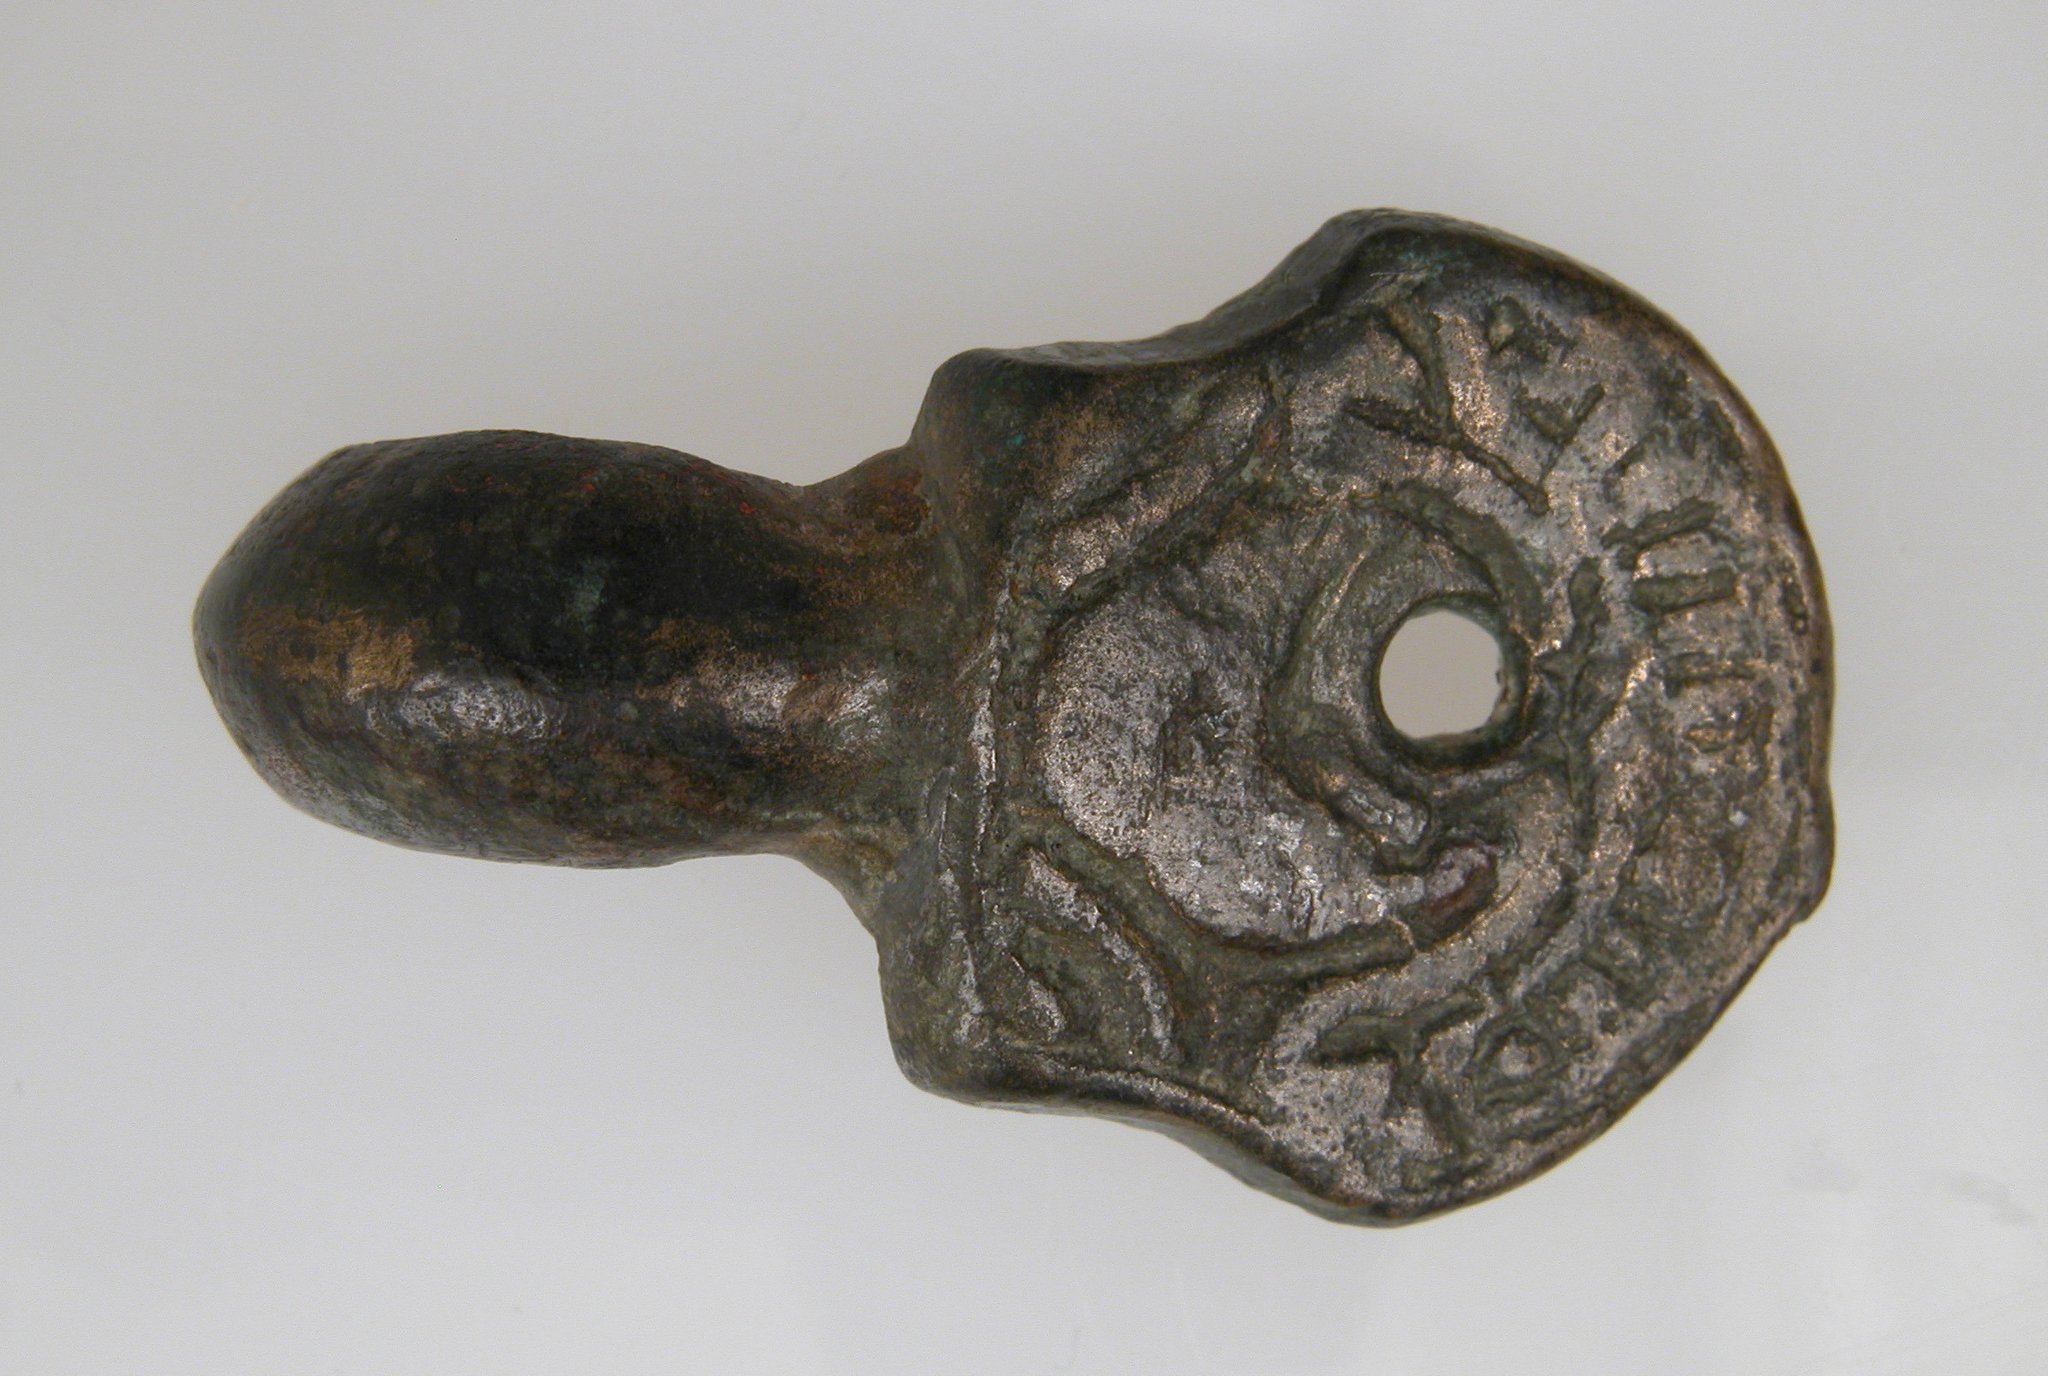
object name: buckle tongue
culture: roman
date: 201-500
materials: copper alloy